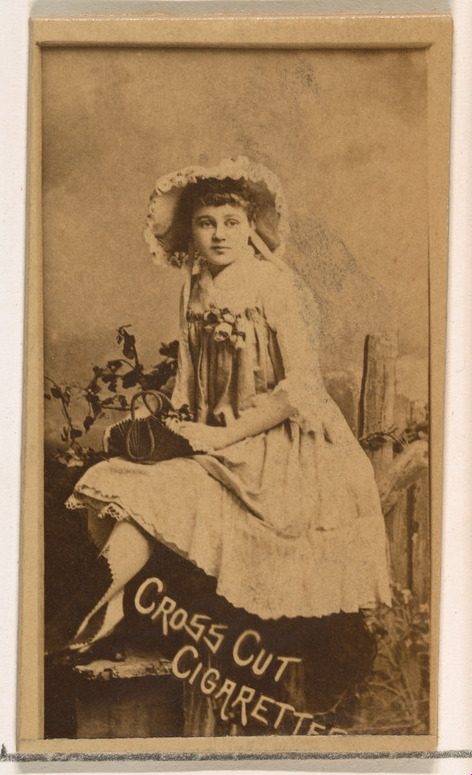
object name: print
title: Seated actress holding bag, from the Actors and Actresses series (N145-1) issued by Duke Sons & Co. to promote Cross Cut Cigarettes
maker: w. duke, sons & co.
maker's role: publisher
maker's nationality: american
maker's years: 1870-1920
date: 1880-1889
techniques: albumen silver print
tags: portraits,women,actresses